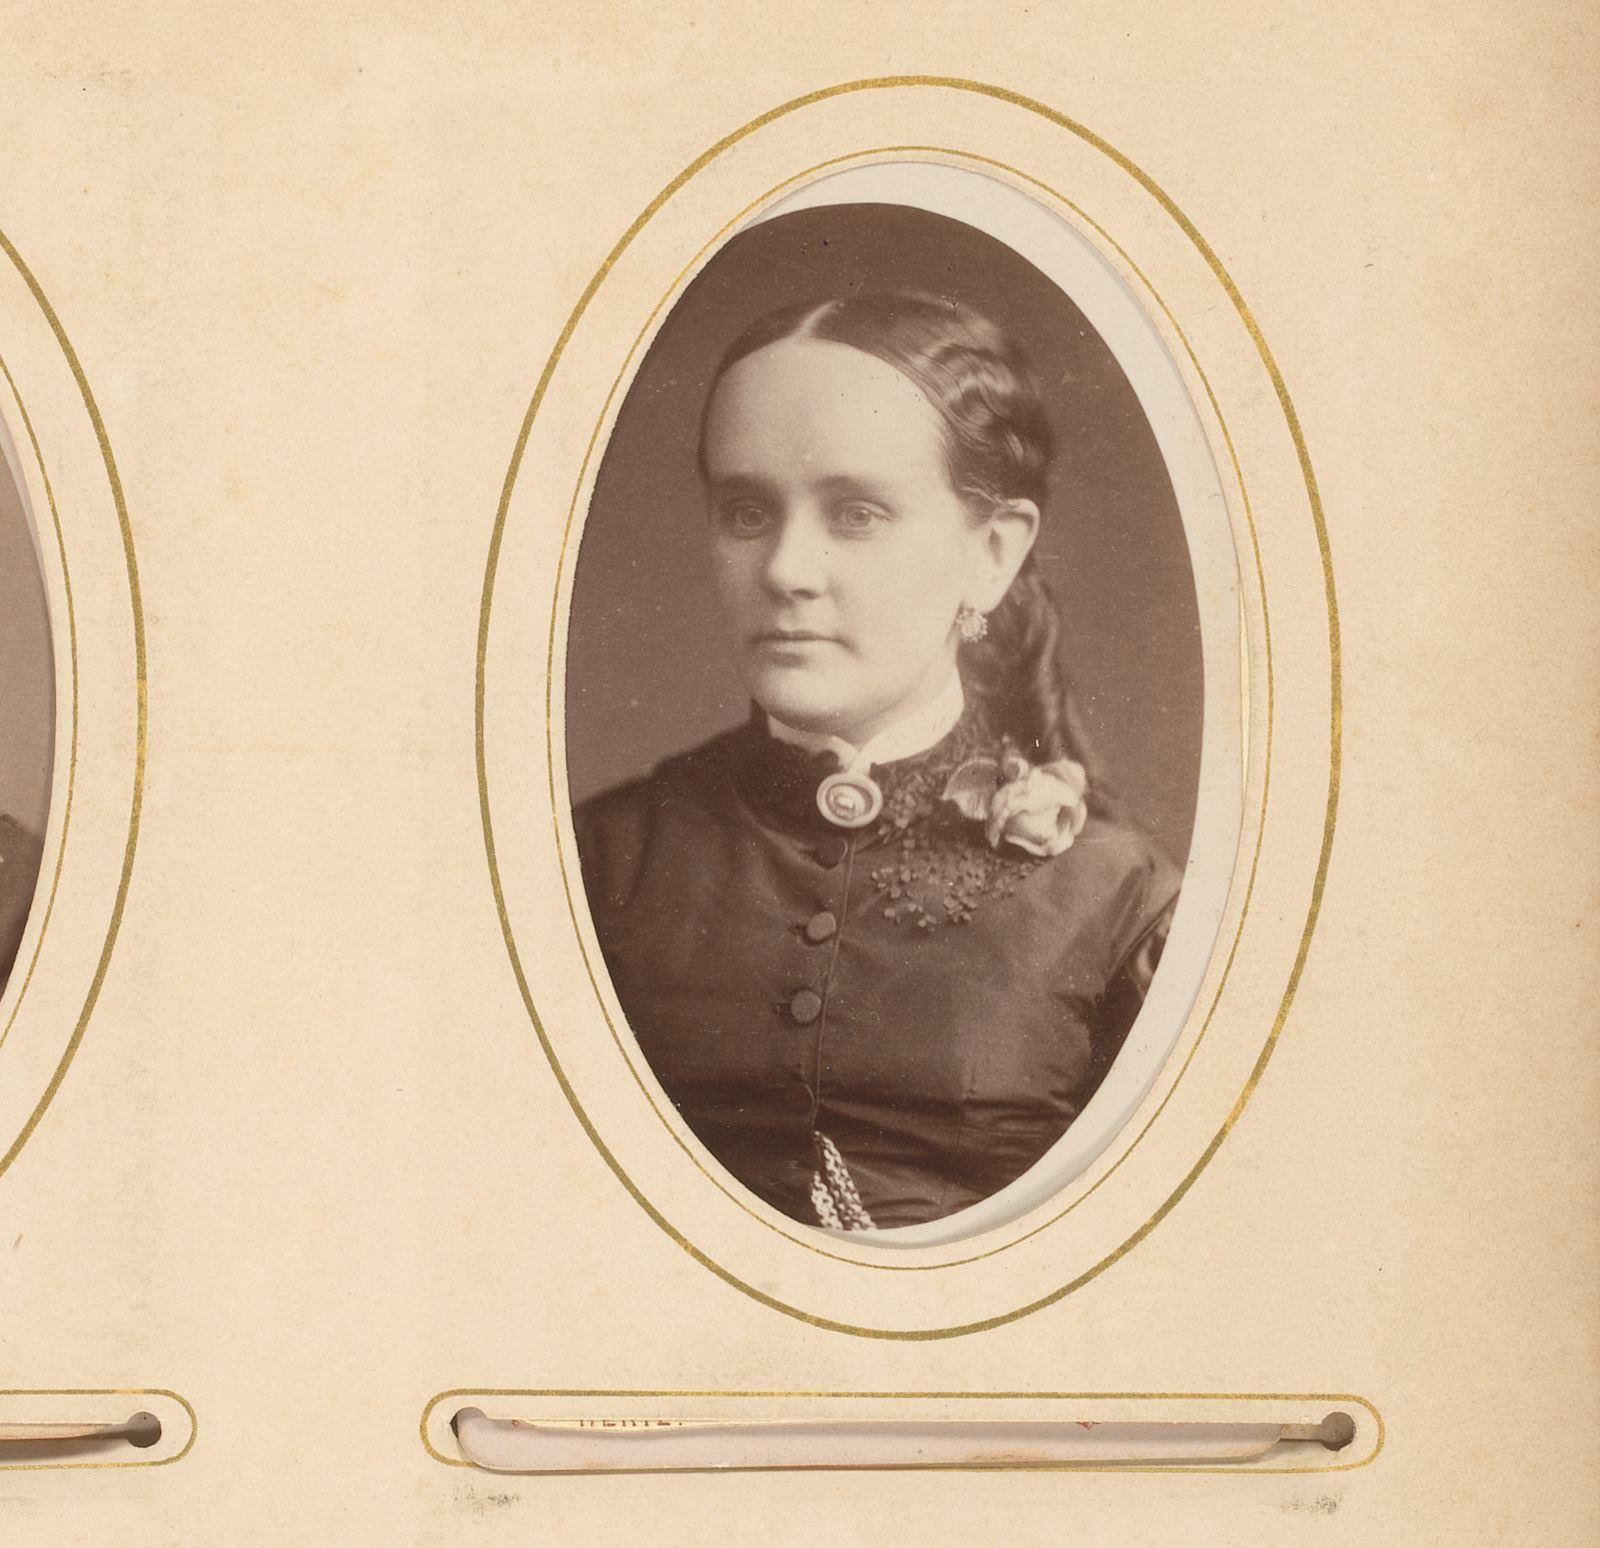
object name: album leaf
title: Portret van een jonge vrouw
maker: hertz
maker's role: fotograaf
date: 1860-1900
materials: cardboard, photographic support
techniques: albumen print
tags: adolescent, young woman, maiden, historical persons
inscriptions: inscription: ‘Albion Studio/ Hertz/ Albion Street/ Opposite the Infirmary/ Hull (...)’